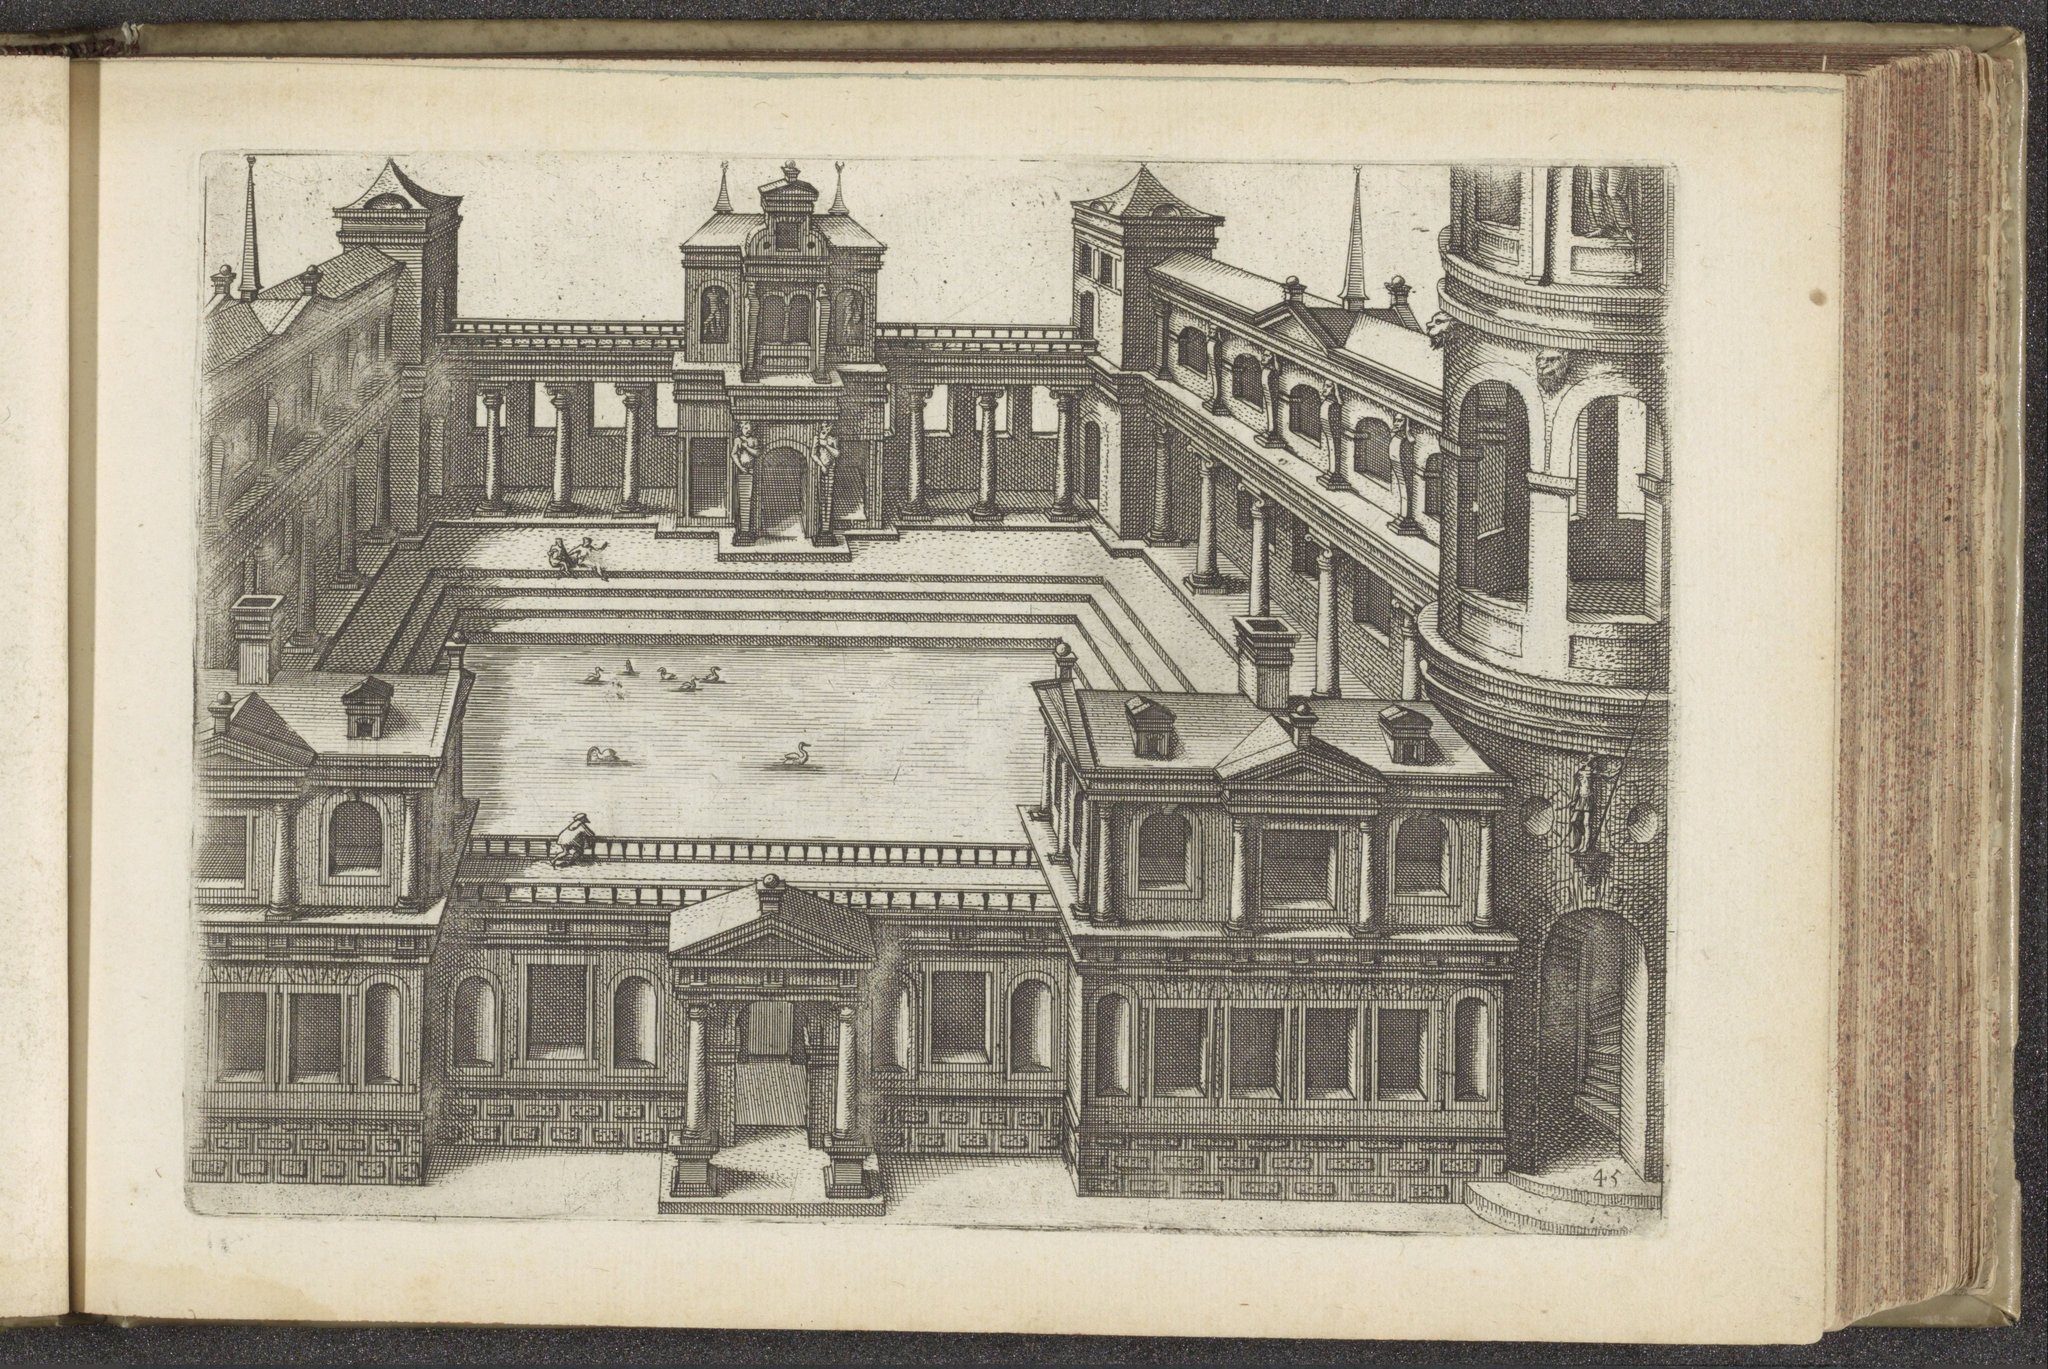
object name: print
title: Kleine architecturale perspectief gezichten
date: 1562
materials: paper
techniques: etching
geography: antwerp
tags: architectural representations in general, pond, pool, courtyard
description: Gezicht op de binnenplaats van een paleis met een vijver waarin eenden zwemmen. Deze prent maakt deel uit van een album.